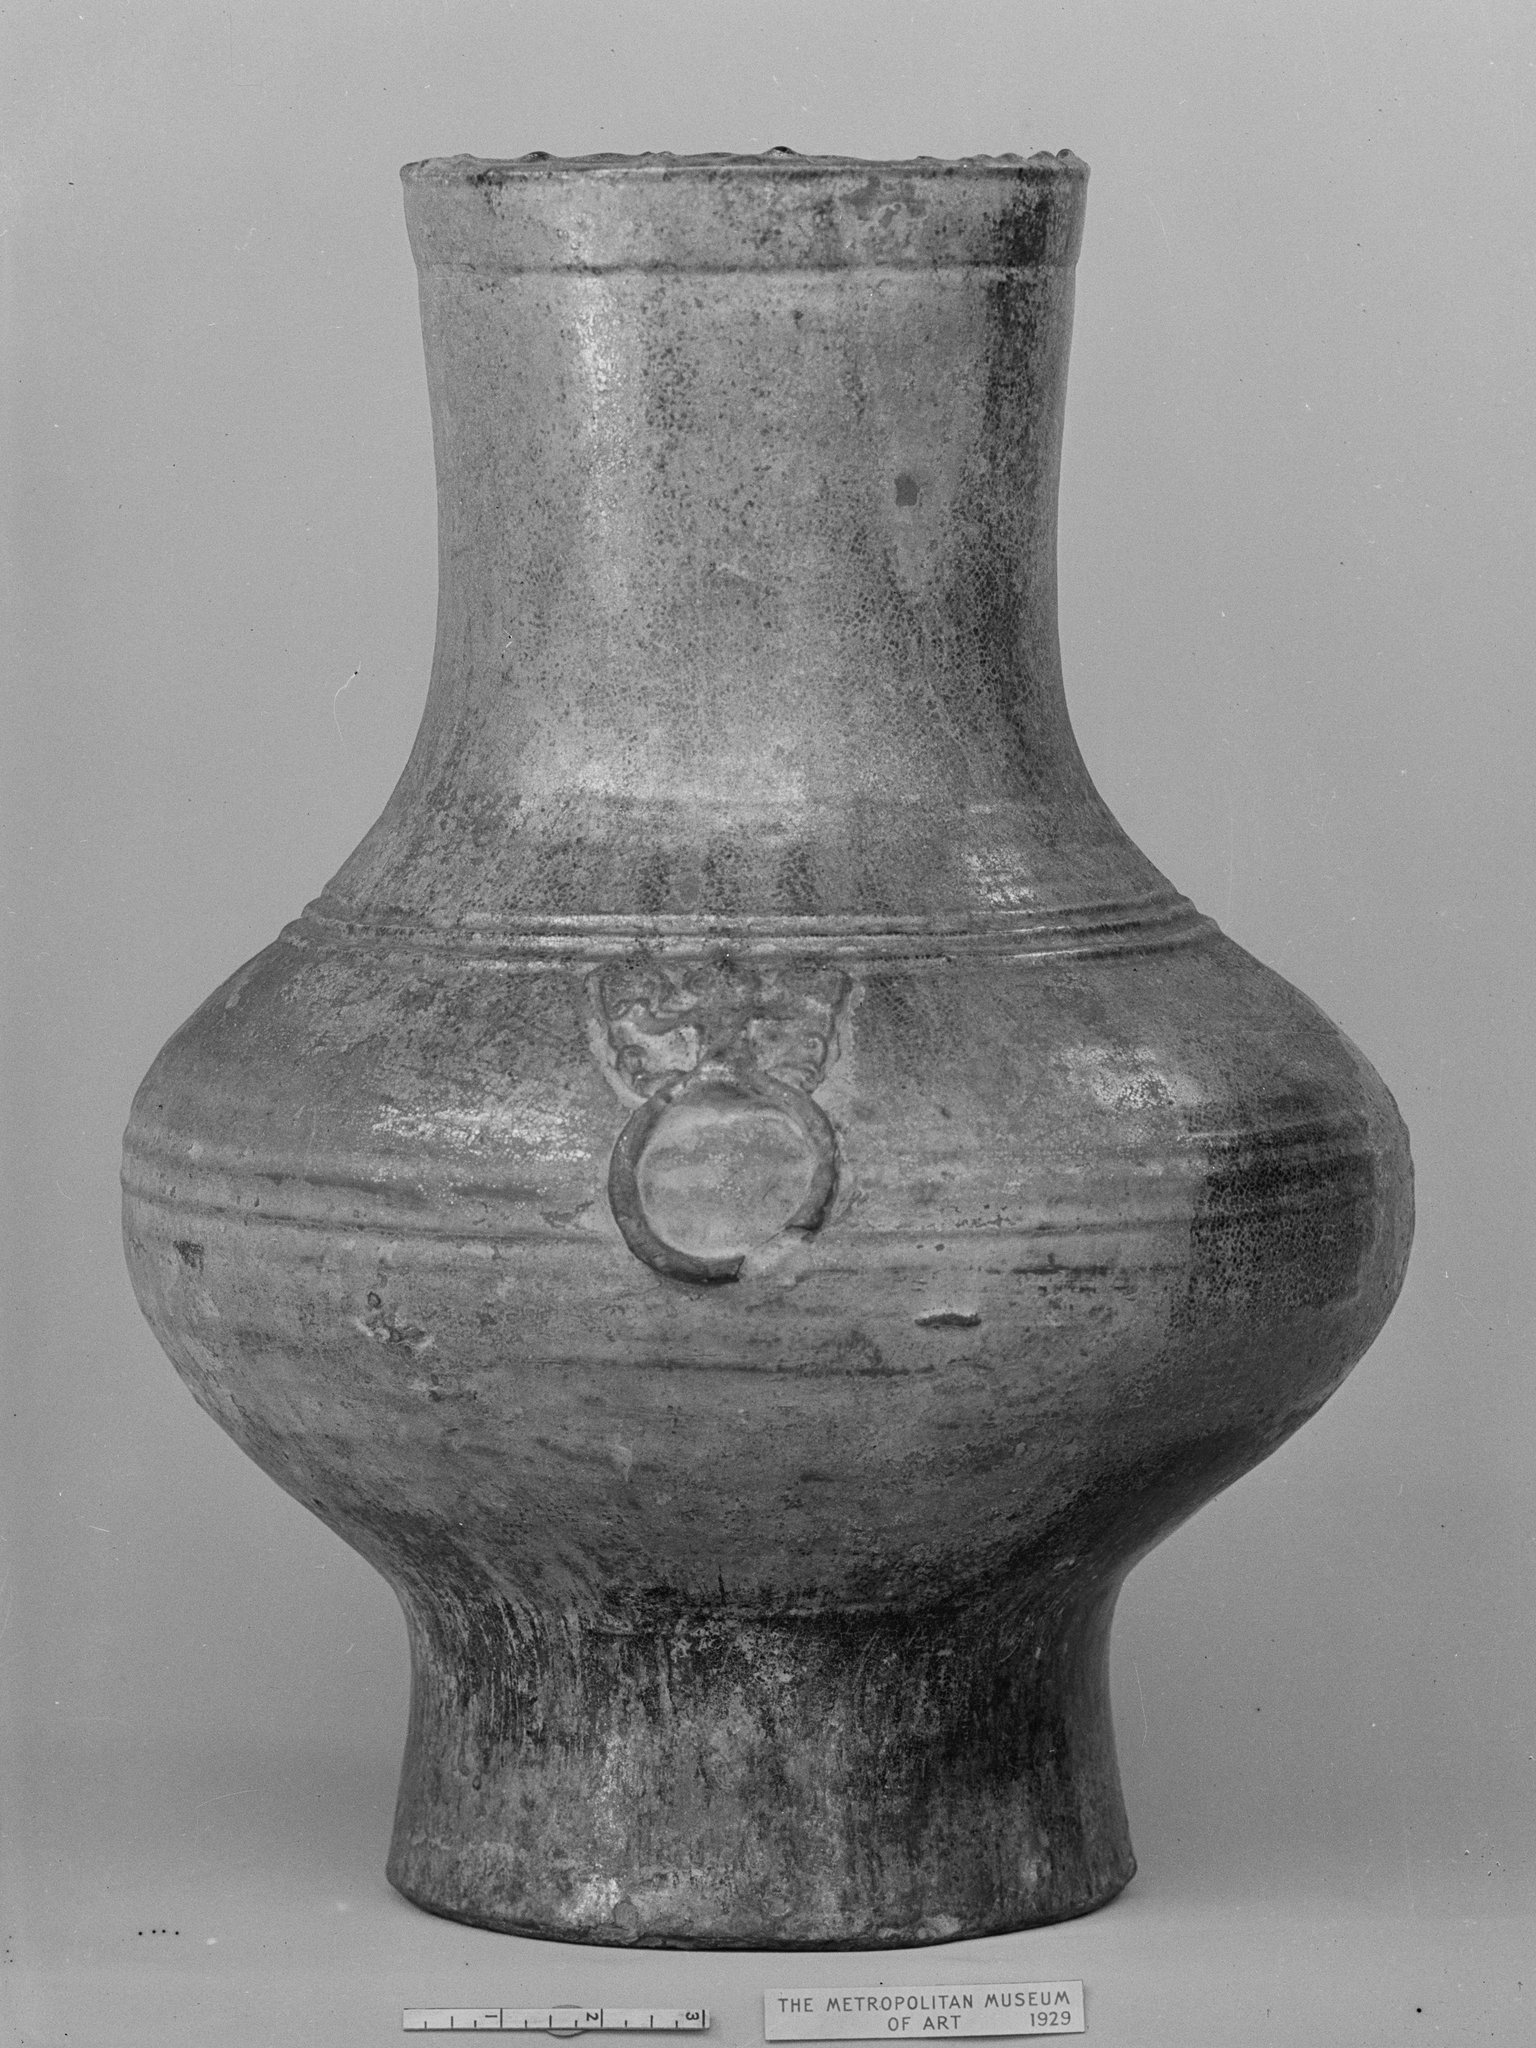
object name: vase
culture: chinese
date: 206 BCE-220 CE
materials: pottery